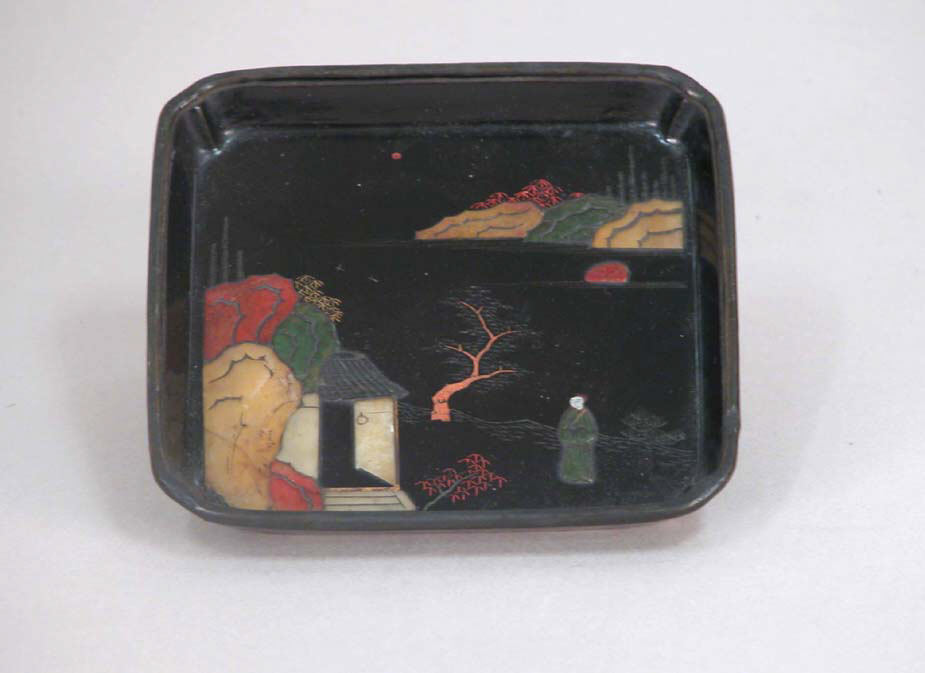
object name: tray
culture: chinese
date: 1601-1700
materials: lacquer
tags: hills,trees